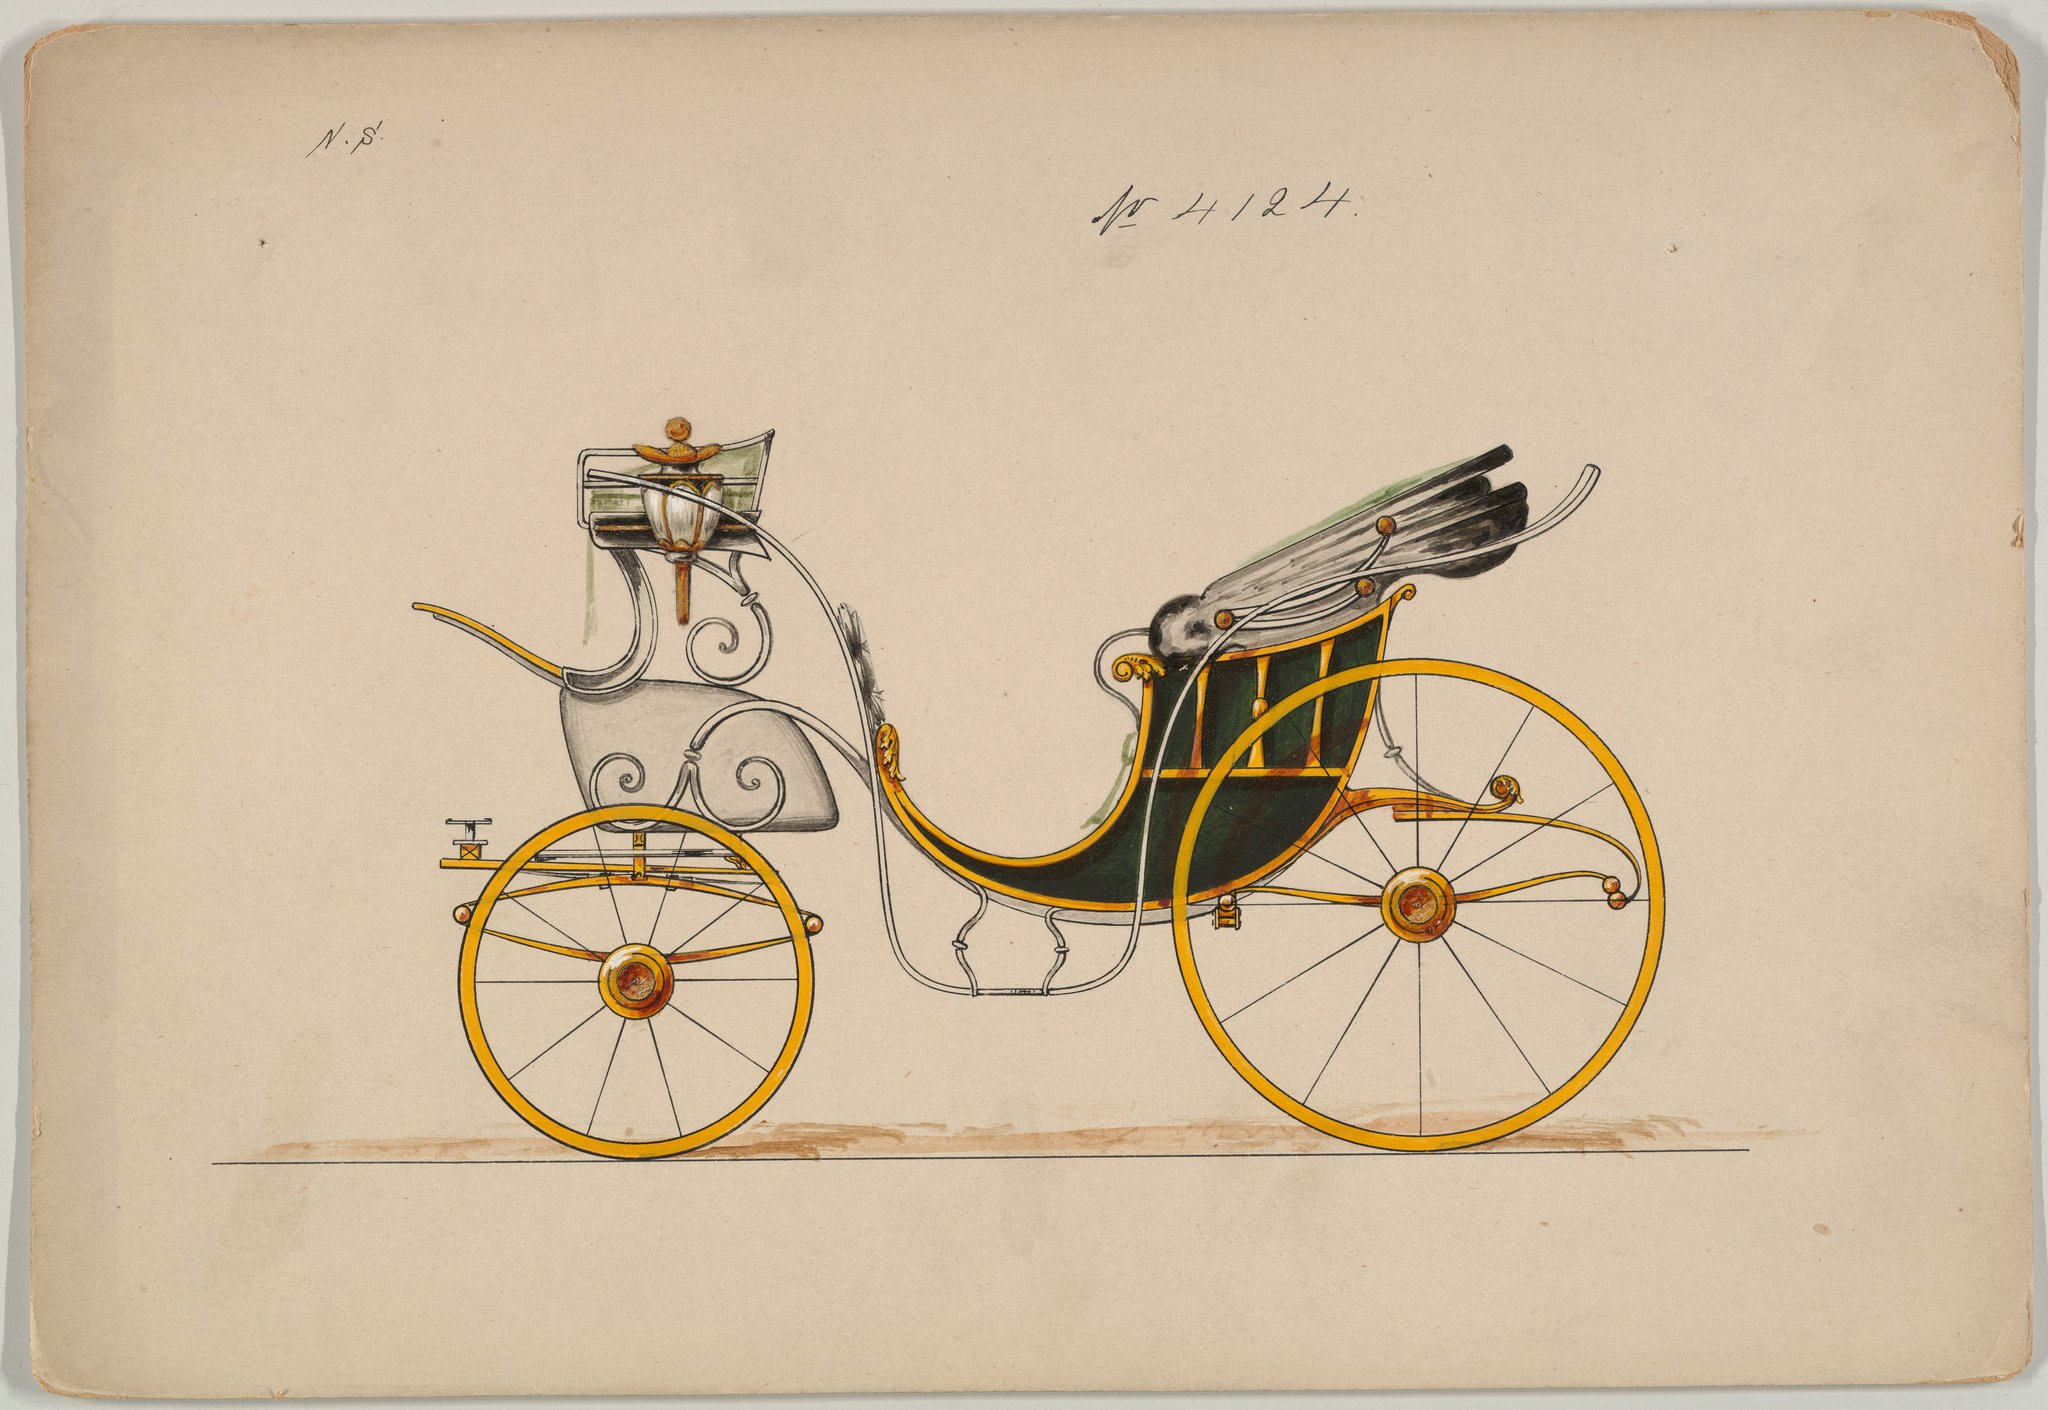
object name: drawing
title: Design for Cabriolet or Victoria, no. 4124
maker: brewster & co.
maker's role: manufacturer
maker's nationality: american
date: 1891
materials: gouache, gum arabic, ink, watercolor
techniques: pen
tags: carriages